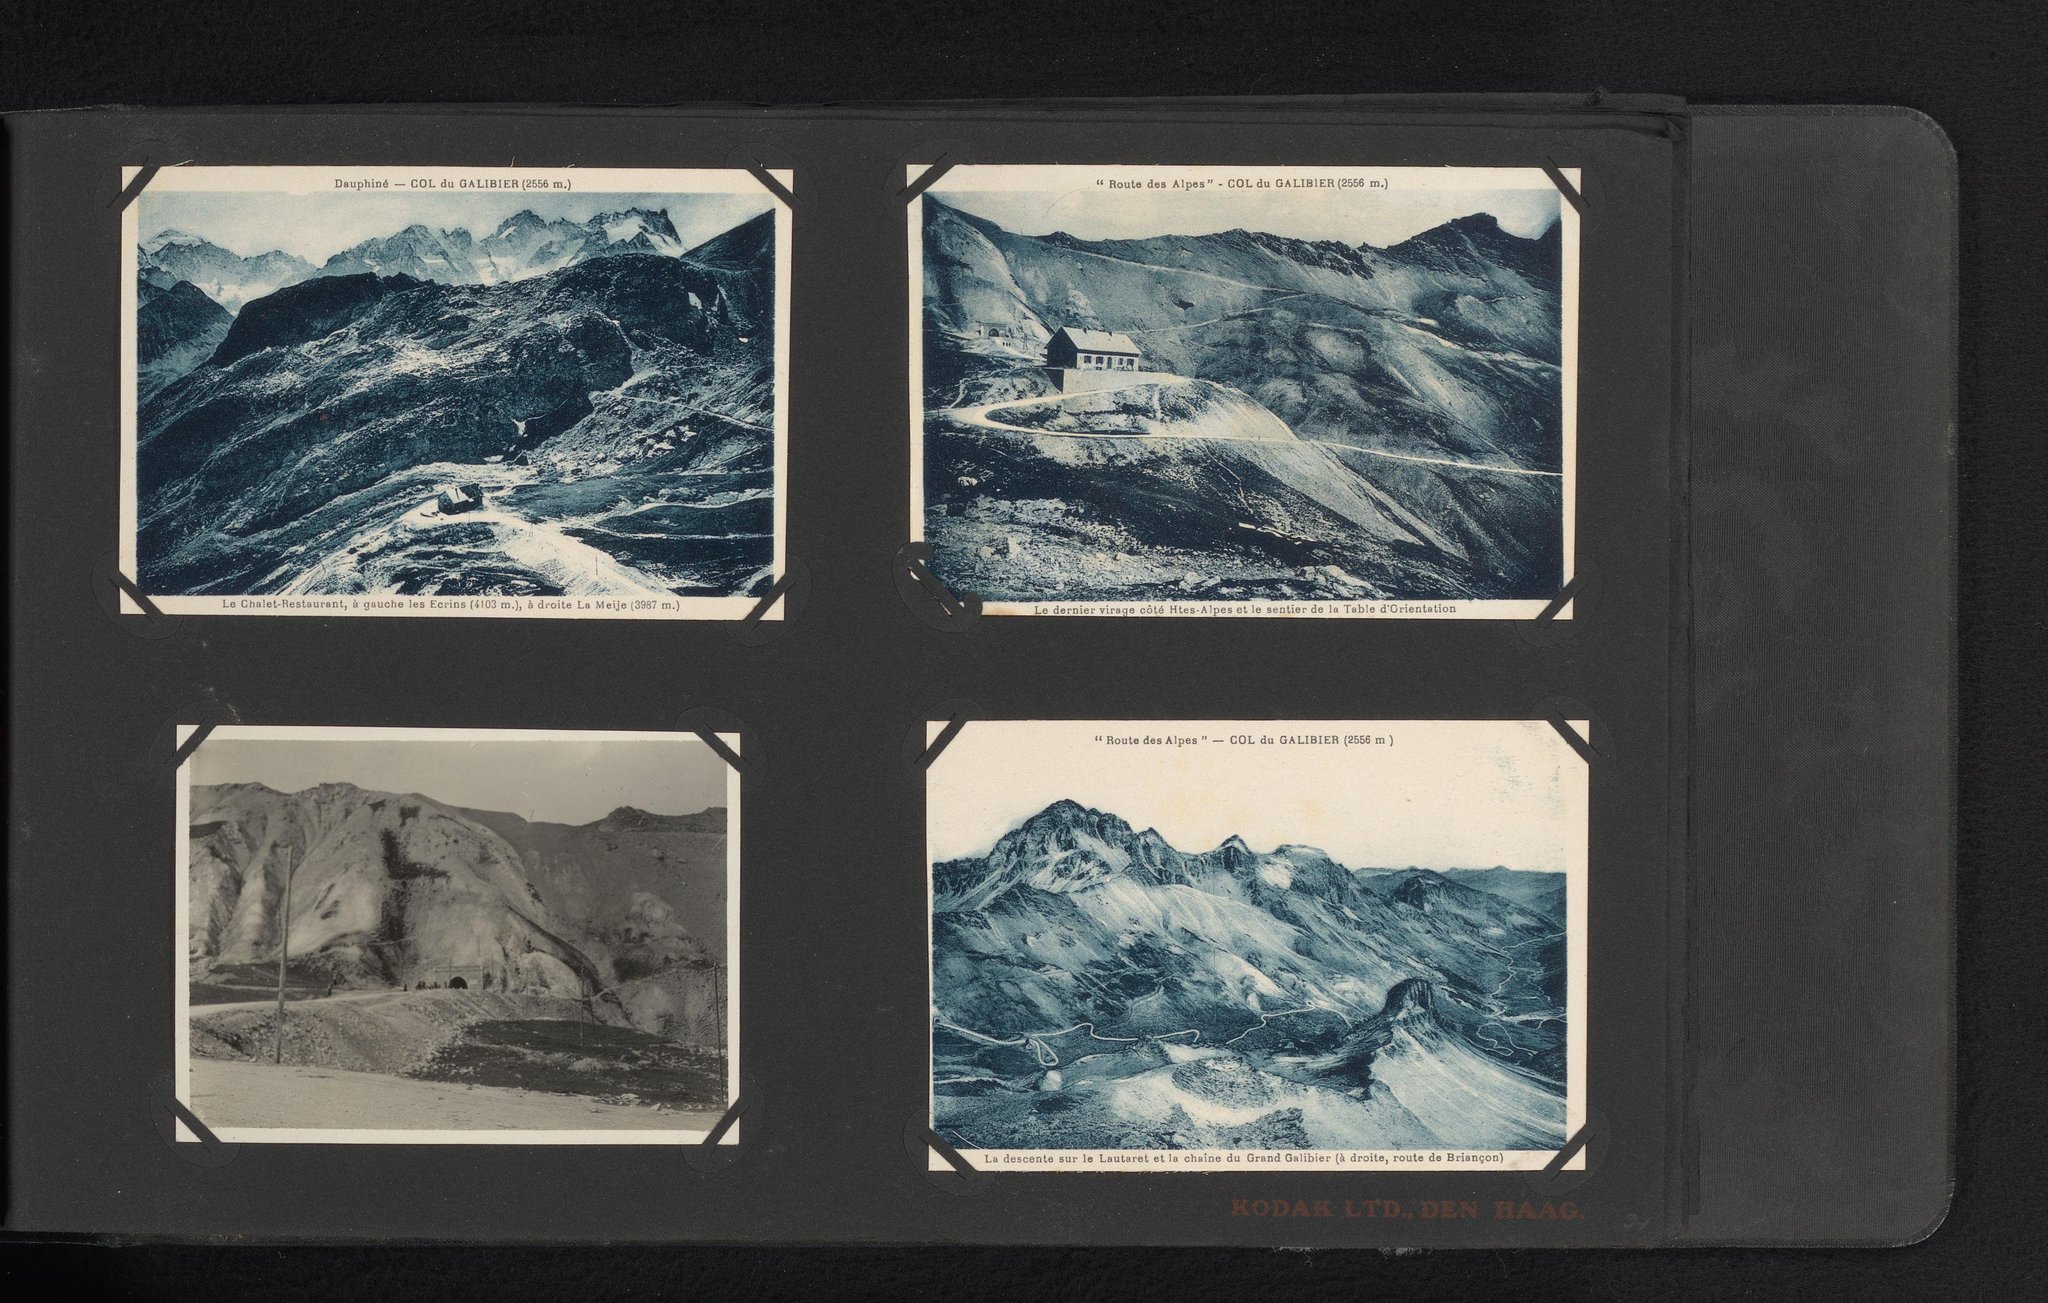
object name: ansichtkaart, prentbriefkaart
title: Drie fotomechanische prentbriefkaarten en een foto van bergen in de Savoie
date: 1908-1929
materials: paper, cardboard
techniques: photograph, gelatin silver print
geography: savoie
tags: mountains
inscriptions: inscription: ‘Kodak Ltd., Den Haag’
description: Deze prenten en foto maken deel uit van een album.